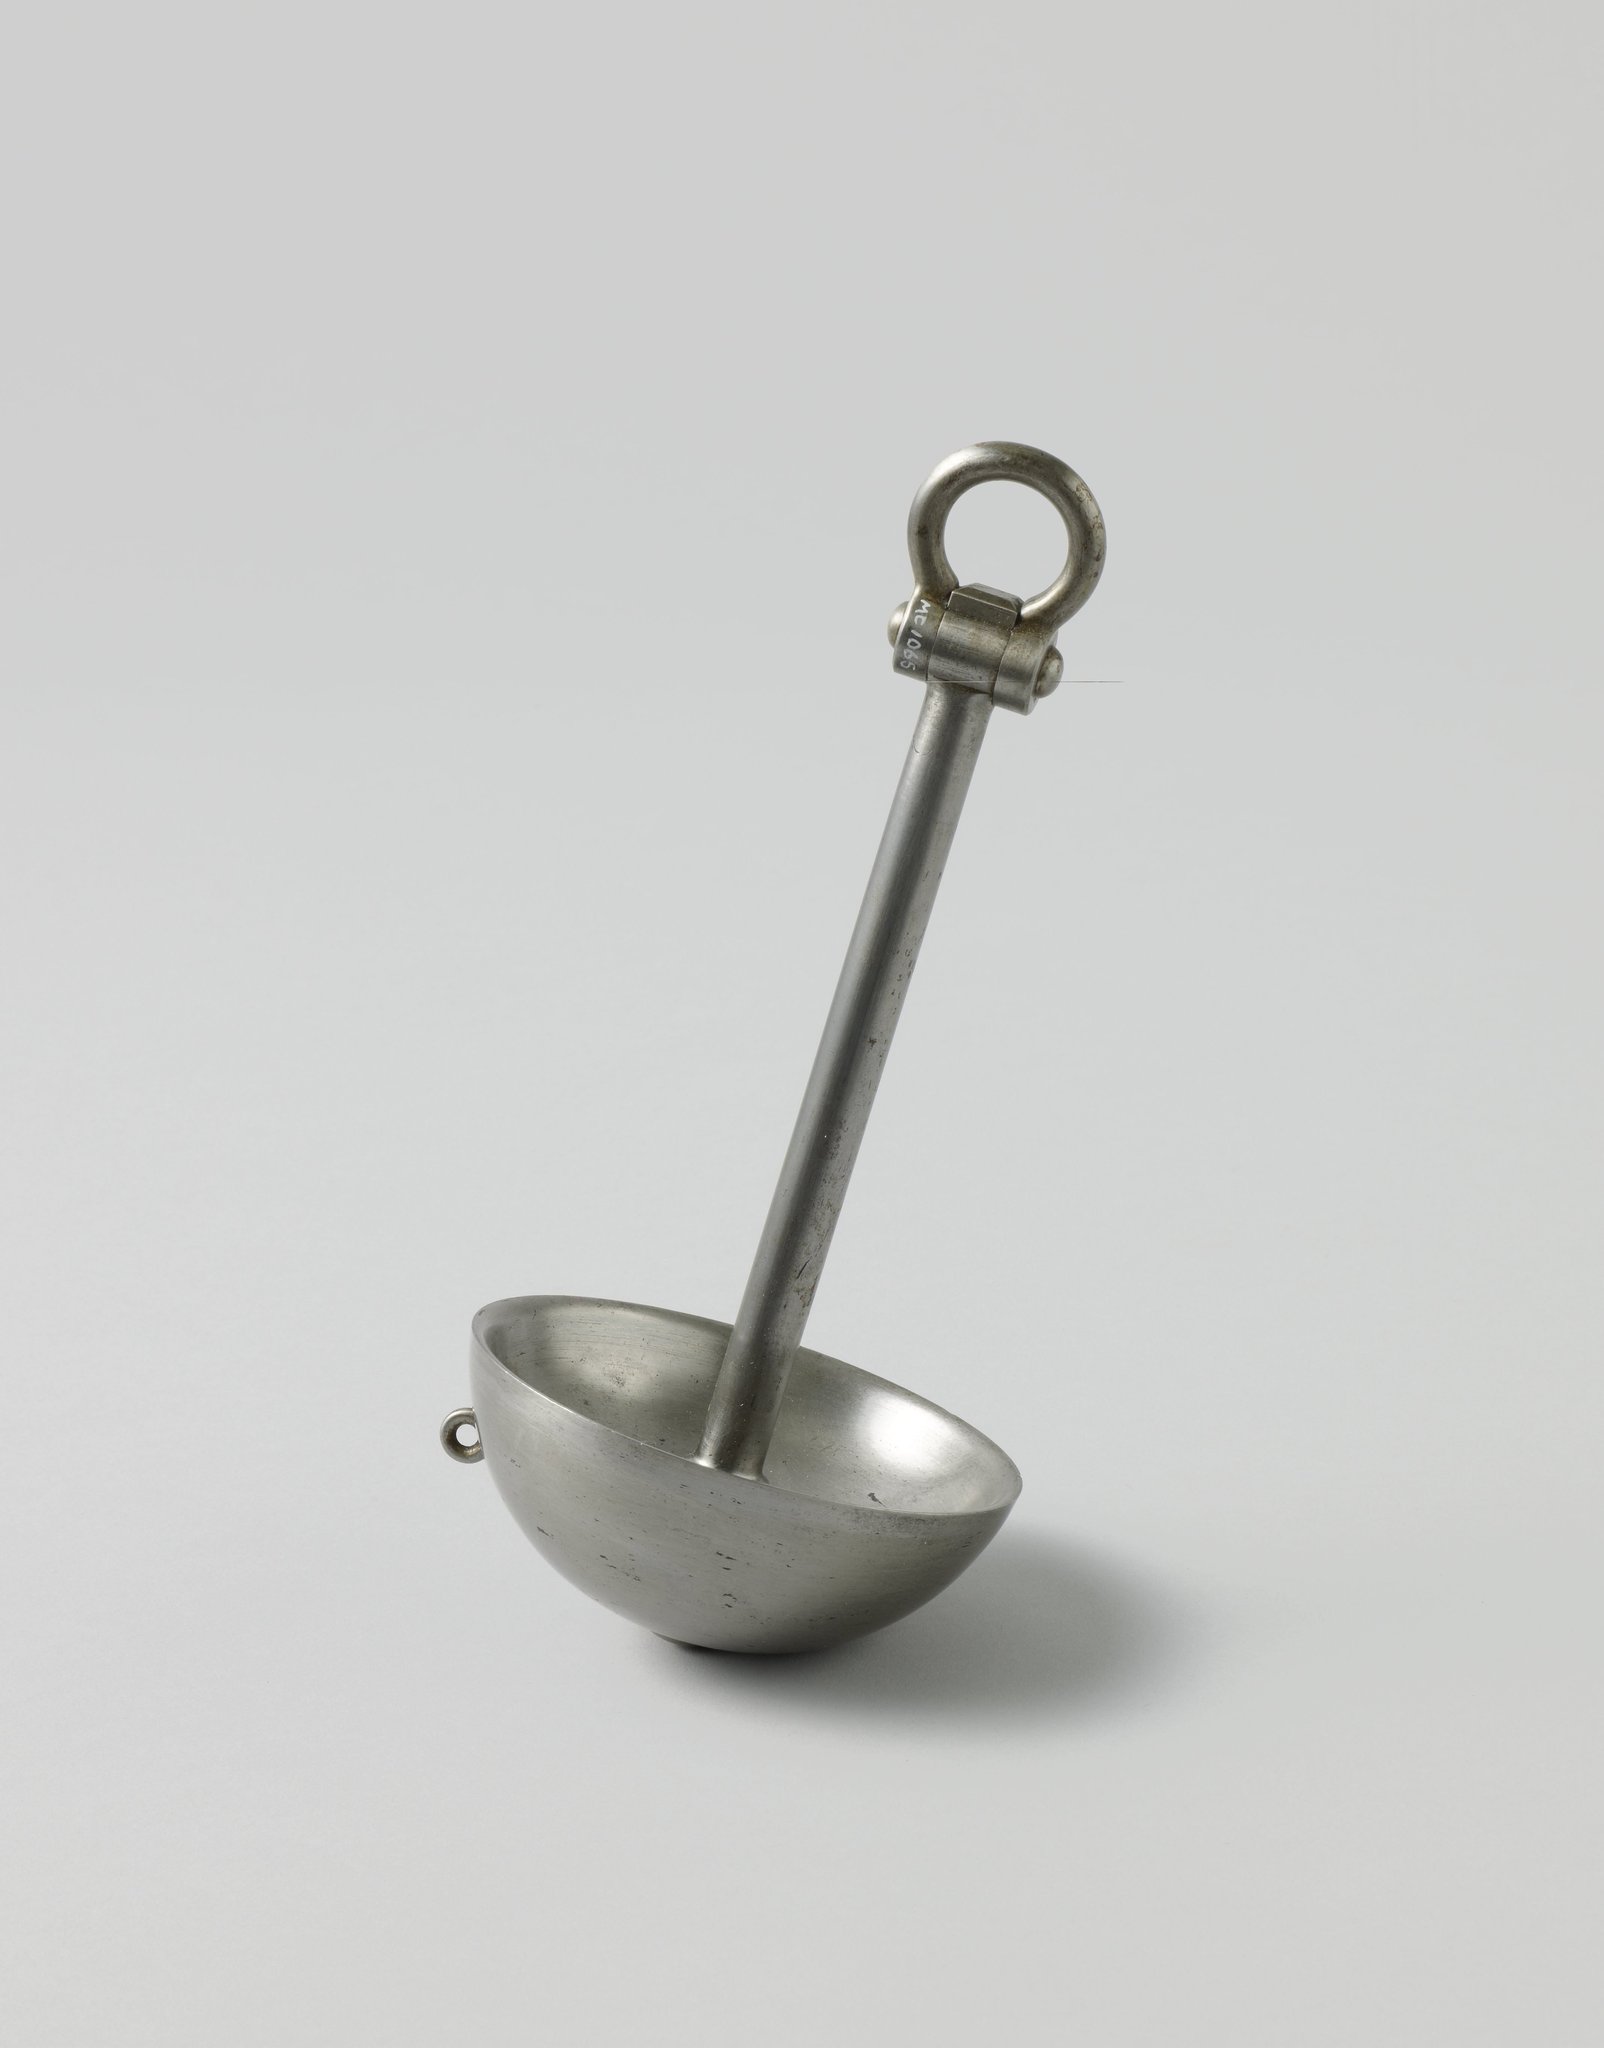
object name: demonstration model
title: Model of an Anchor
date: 1860-1863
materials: iron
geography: leiden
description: Model van een paddestoel-anker. Het bestaat uit een schacht met een harp aan het einde, terwijl de armen vervangen zijn door de sectie van een bol, naar het midden verzwaard. Hieraan is nog een oog bevestigd. Schaal 1:10 (schatting).